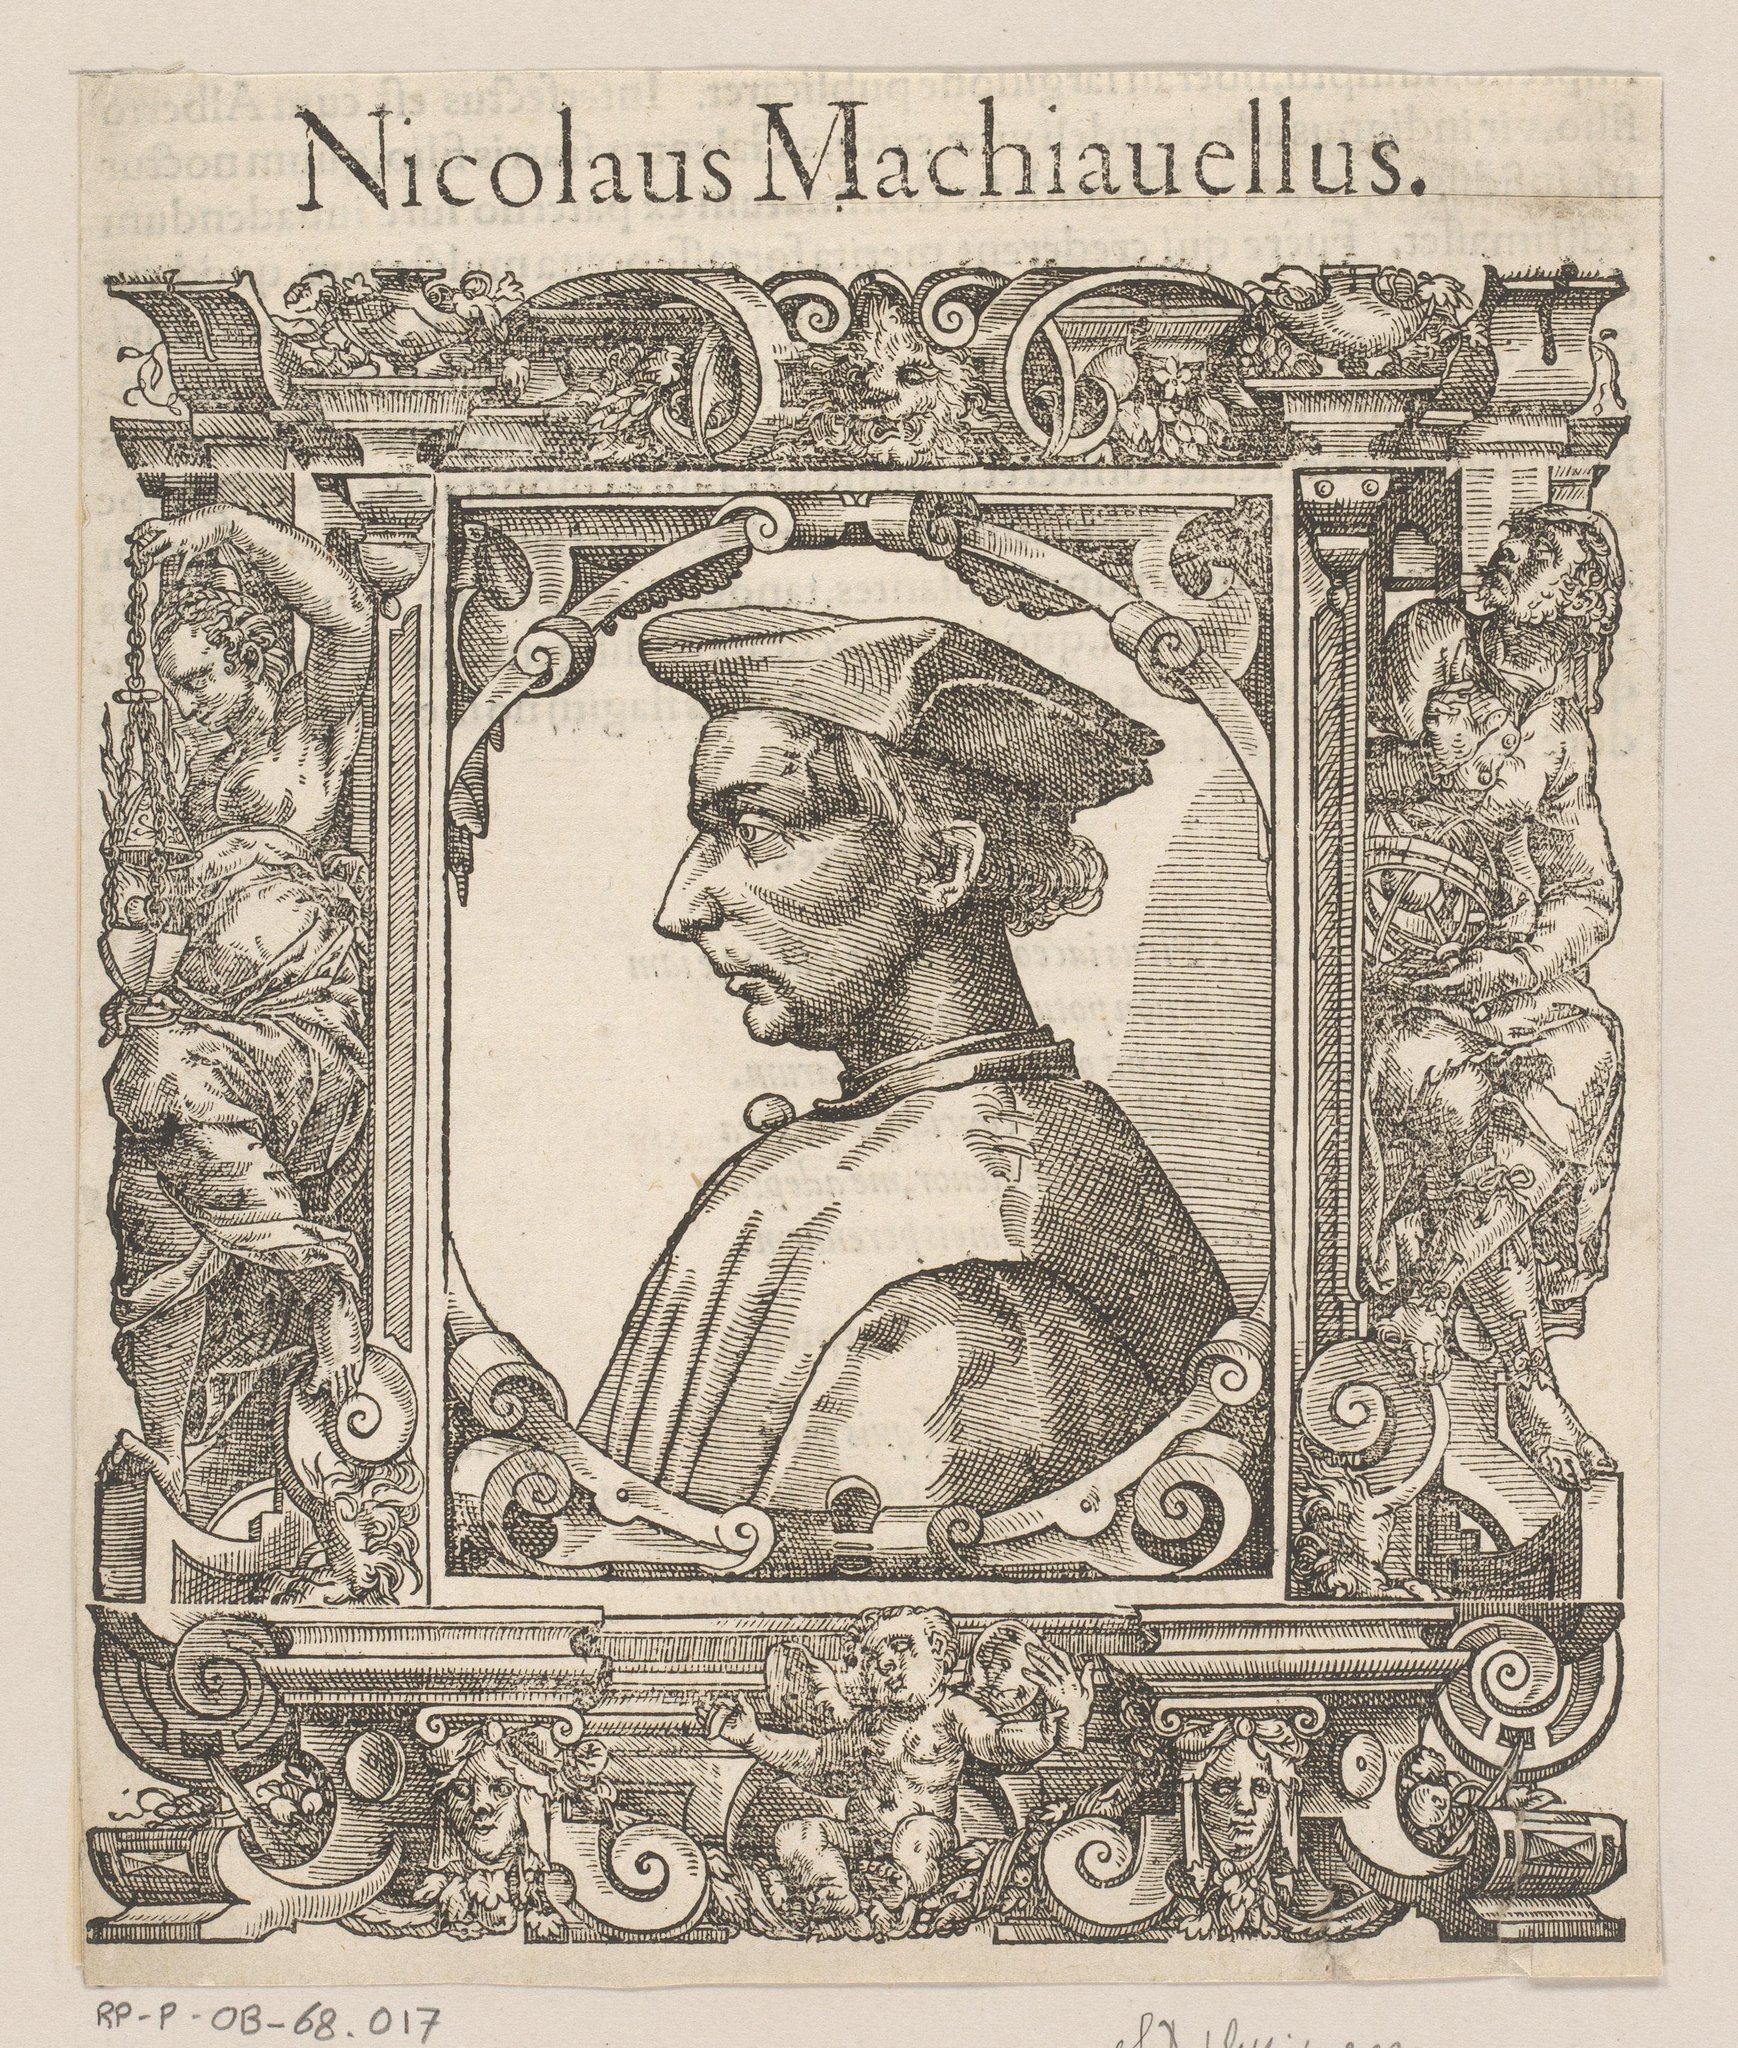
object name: print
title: Portret Niccolò Machiavelli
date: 1577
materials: paper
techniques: letterpress printing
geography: basel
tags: politician, historical persons, portrait of a writer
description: Prent uit: Giovio, Paolo. Elogia virorum literis illustrium, quotquot (...). Bazel: Peter Perna, 1577, p. 162. Prent ook gebruikt in latere publicaties.